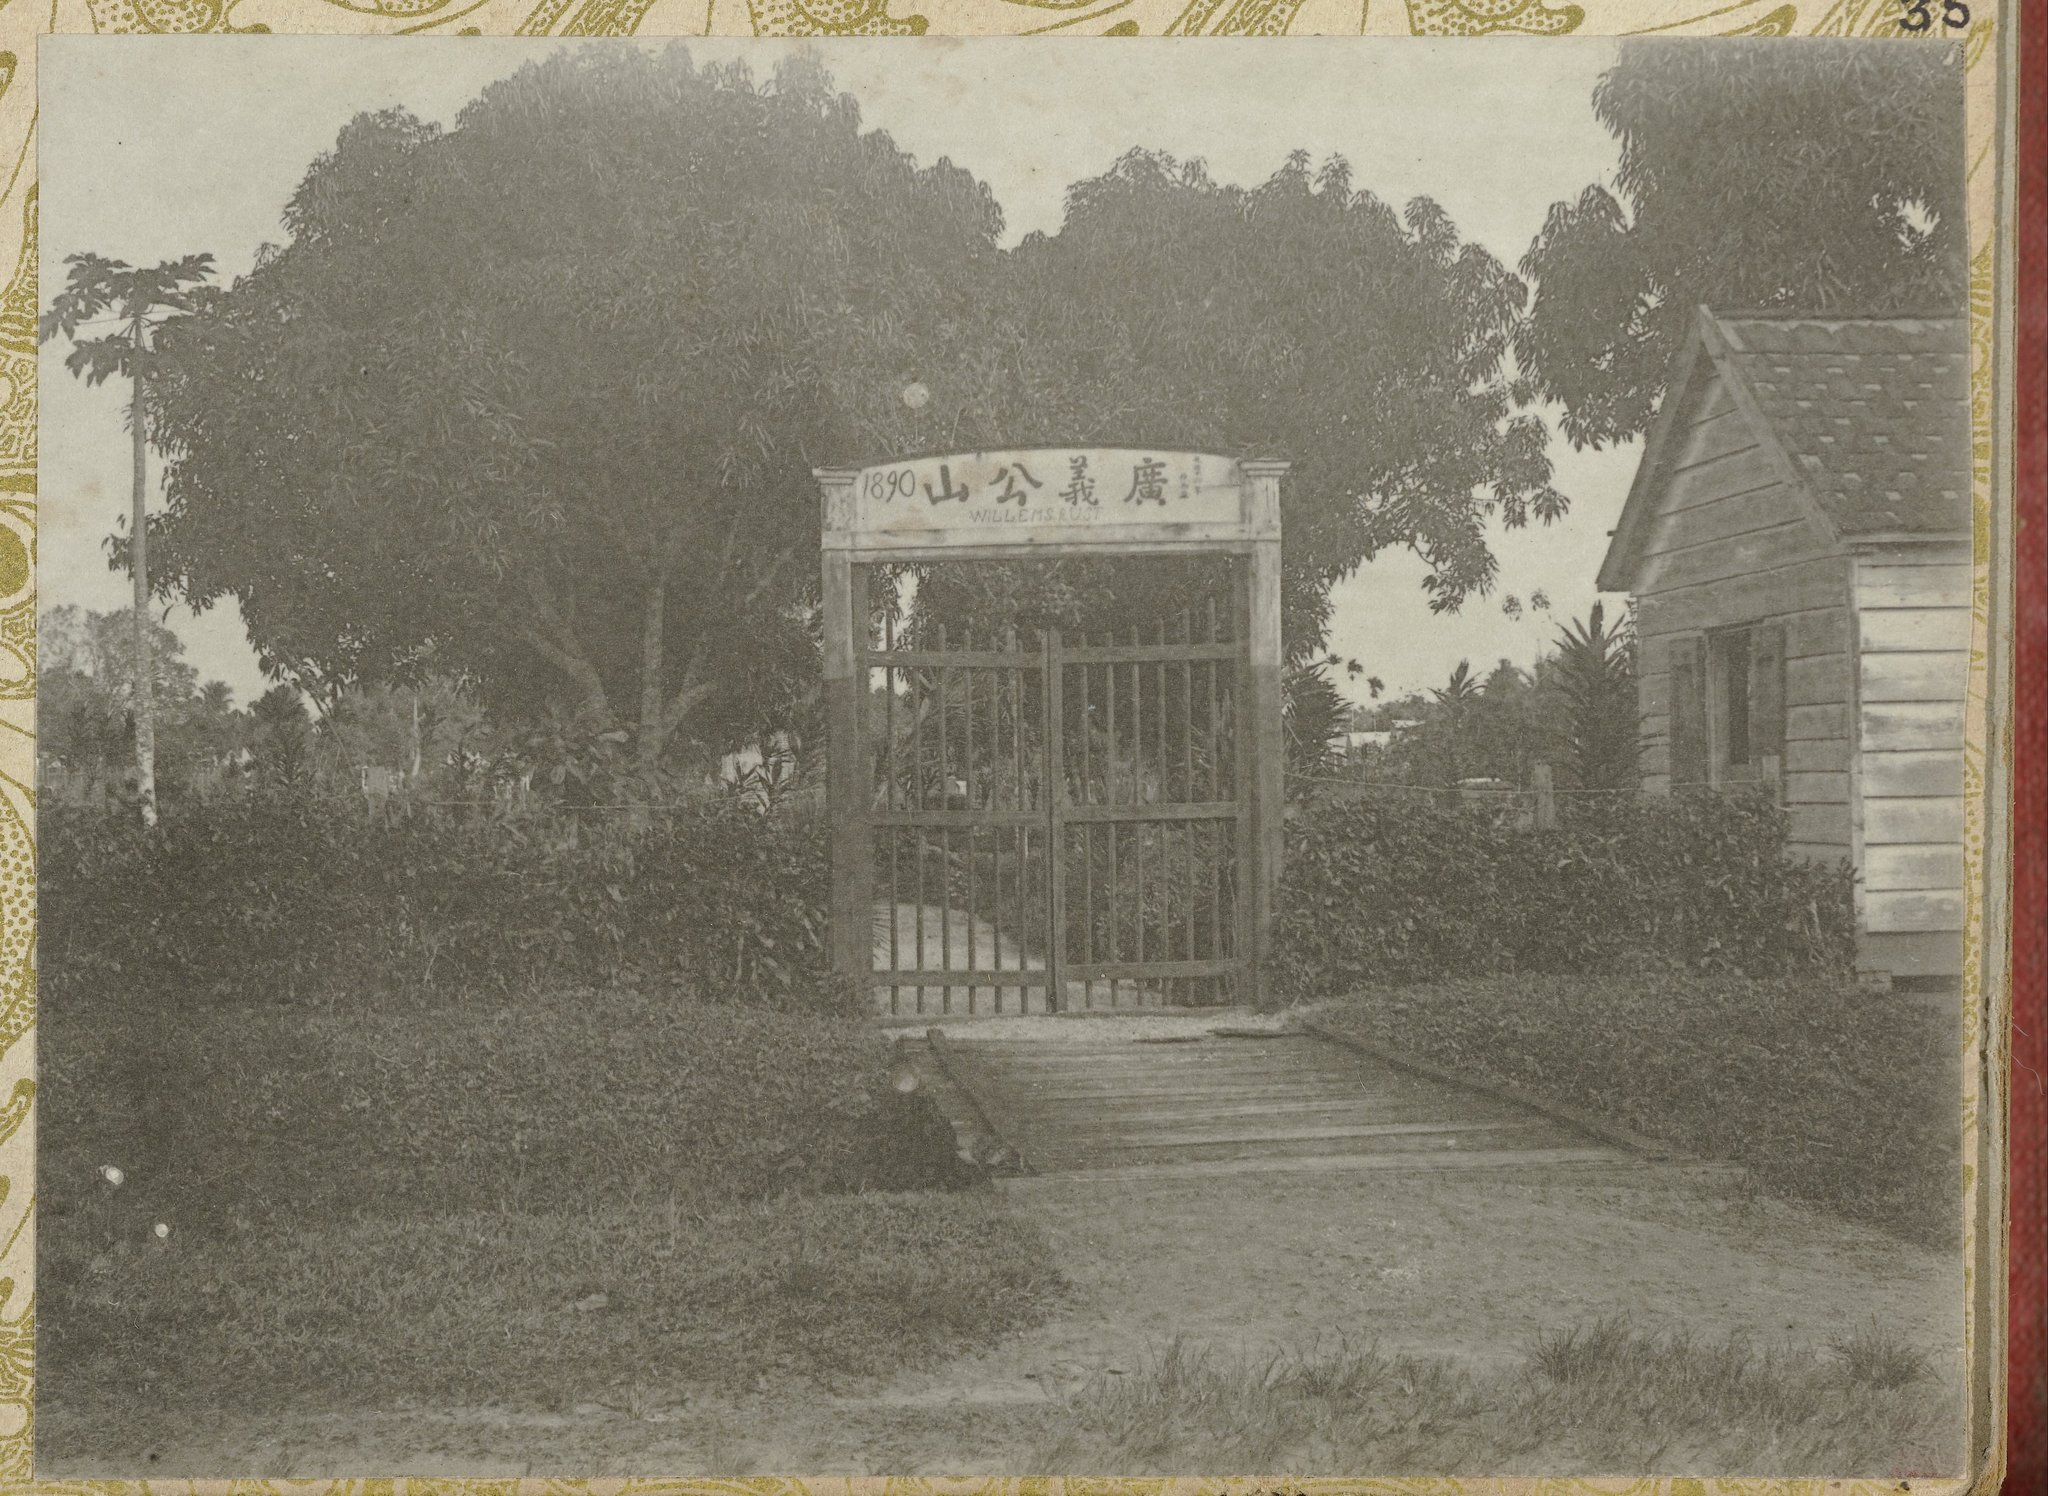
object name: photograph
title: Ingang Wanicastraat van Chineesch kerkhof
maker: hendrik doijer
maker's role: engineer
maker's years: 1863-1925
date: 1903-1910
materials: photographic support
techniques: gelatin silver print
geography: suriname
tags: suriname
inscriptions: inscription: ‘35’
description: Toegangshek naar het Chinese kerkhof aan de Wanicastraat te Paramaribo, boven het hek een bord met Chinese tekens, het jaartal 1890 en de naam Willemsrust of Willems Rust. Onderdeel van het fotoalbum Souvenir de Voyage (deel 2), over het leven van de familie Doijer in en rond de plantage Ma Retraite in Suriname in de jaren 1903-1910.